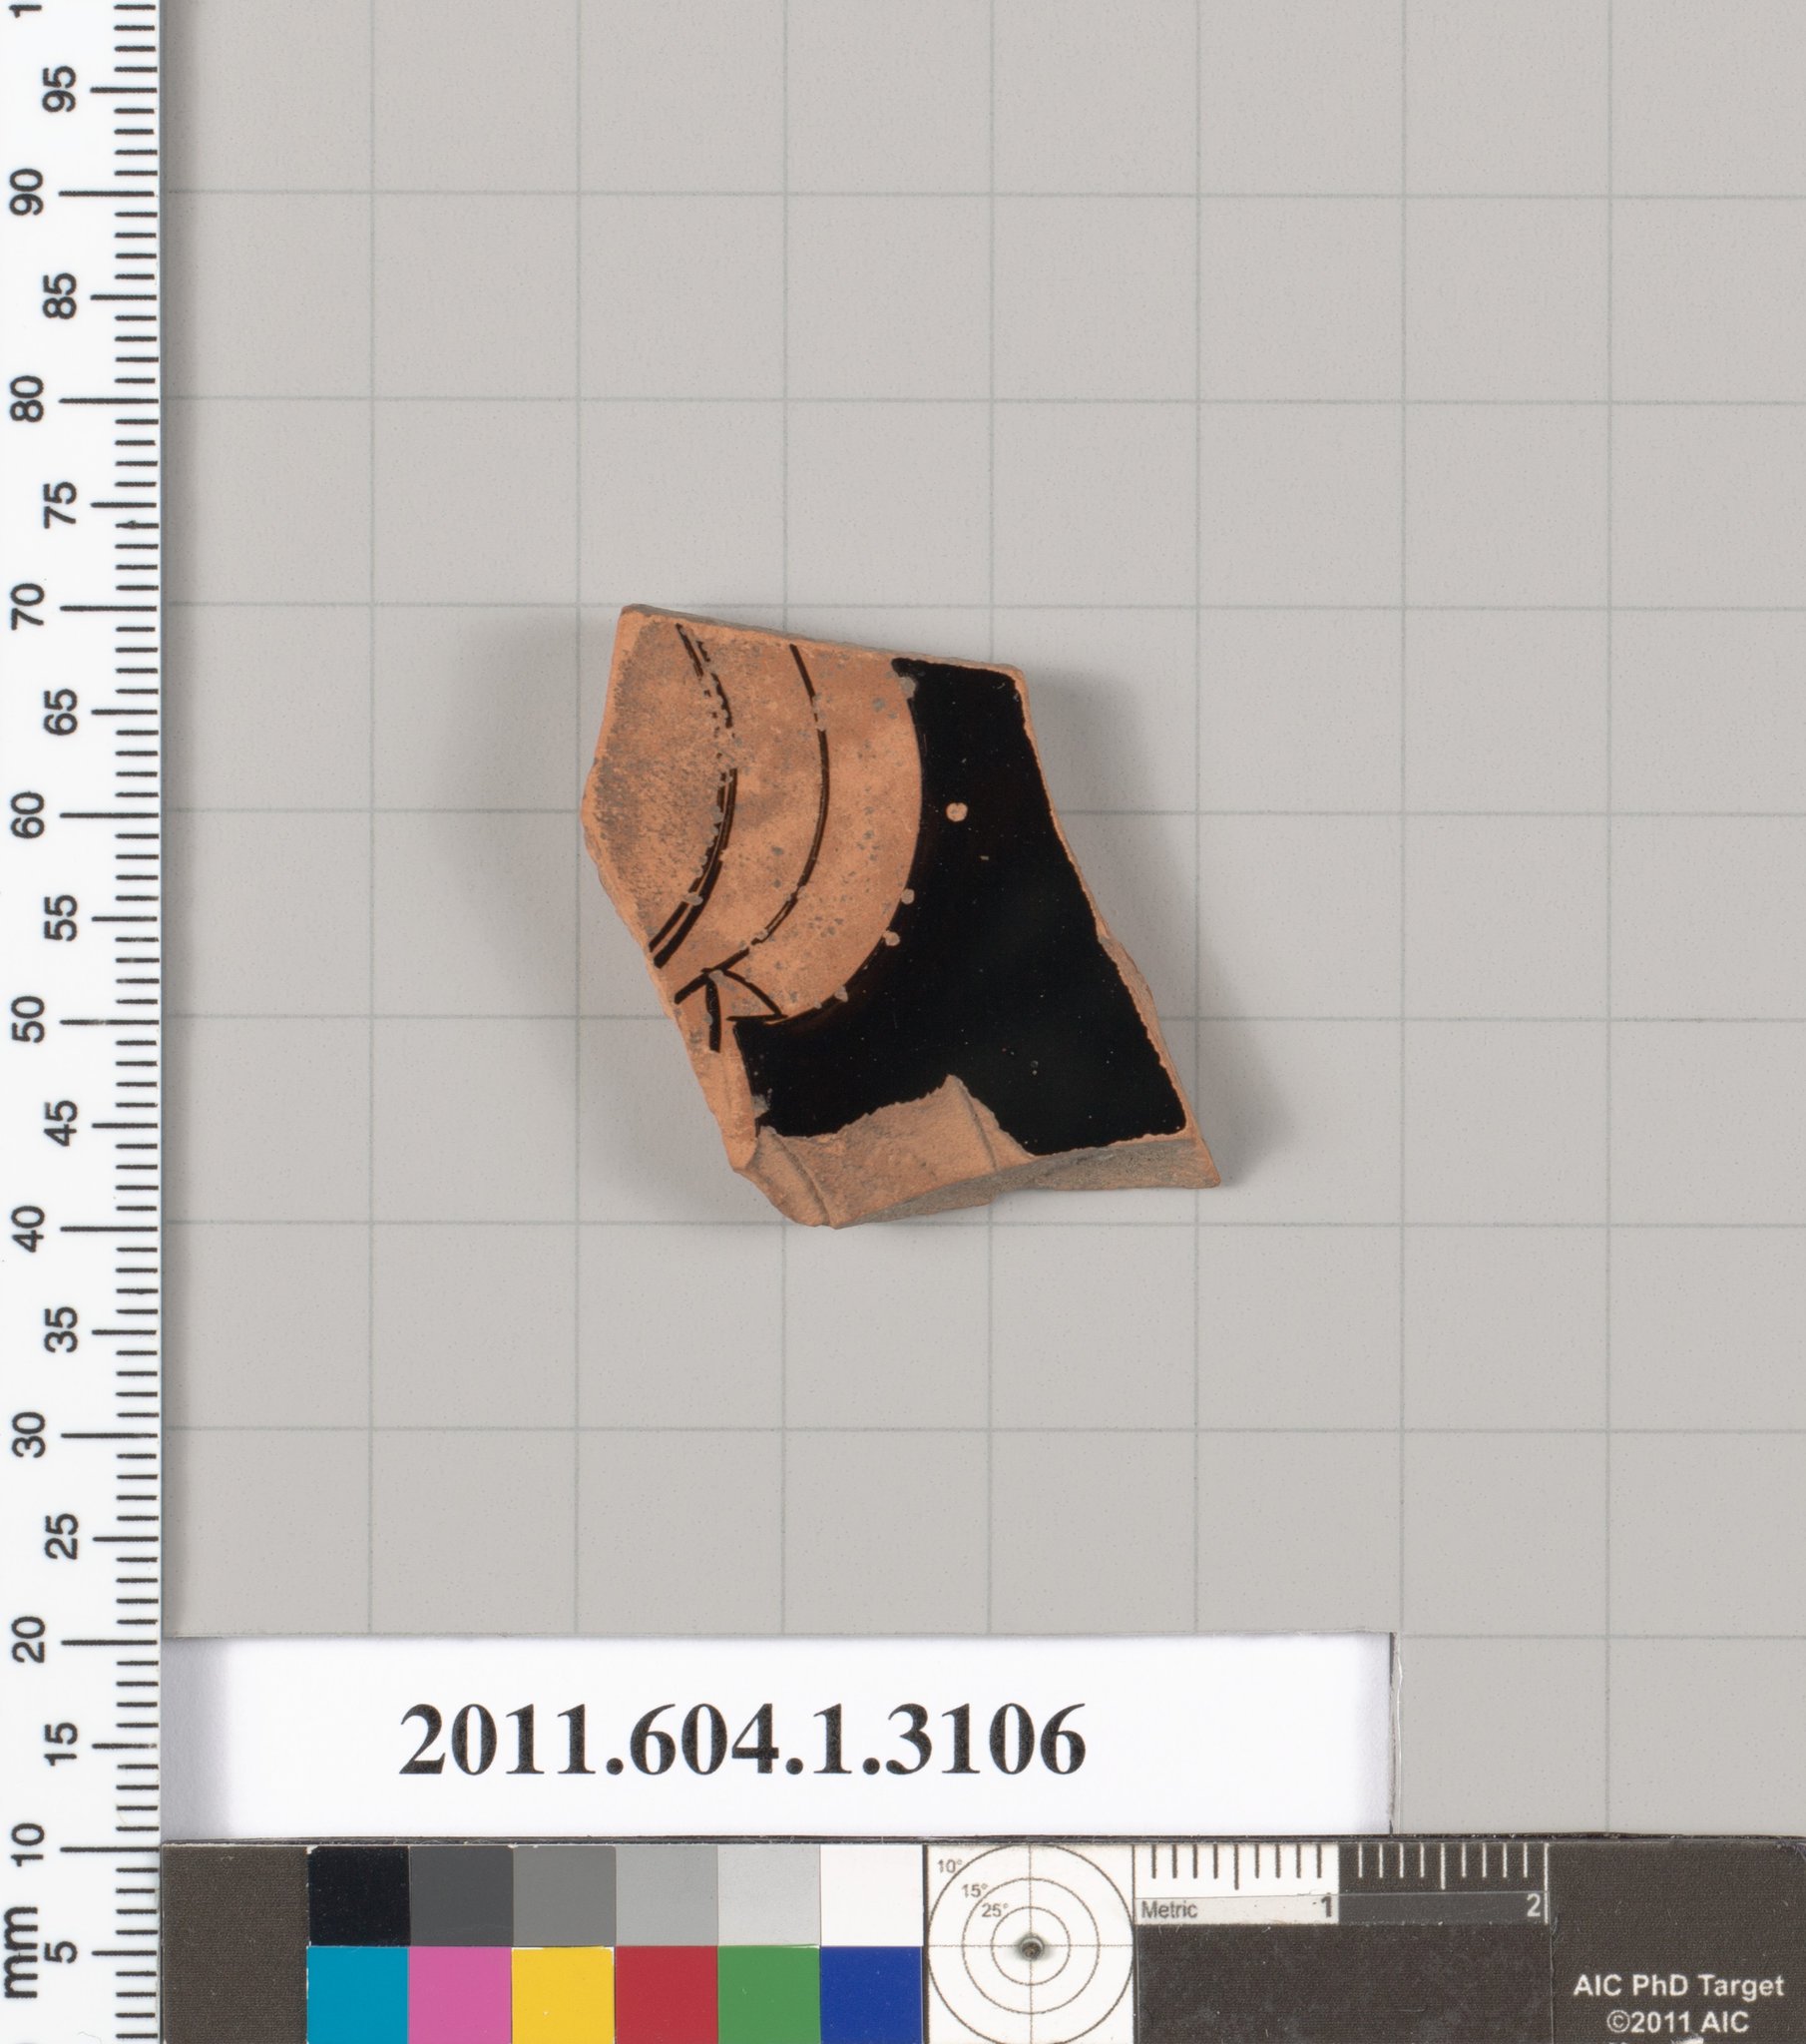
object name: kylix fragment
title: Terracotta fragment of a kylix (drinking cup)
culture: greek, attic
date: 500-480 BCE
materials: terracotta